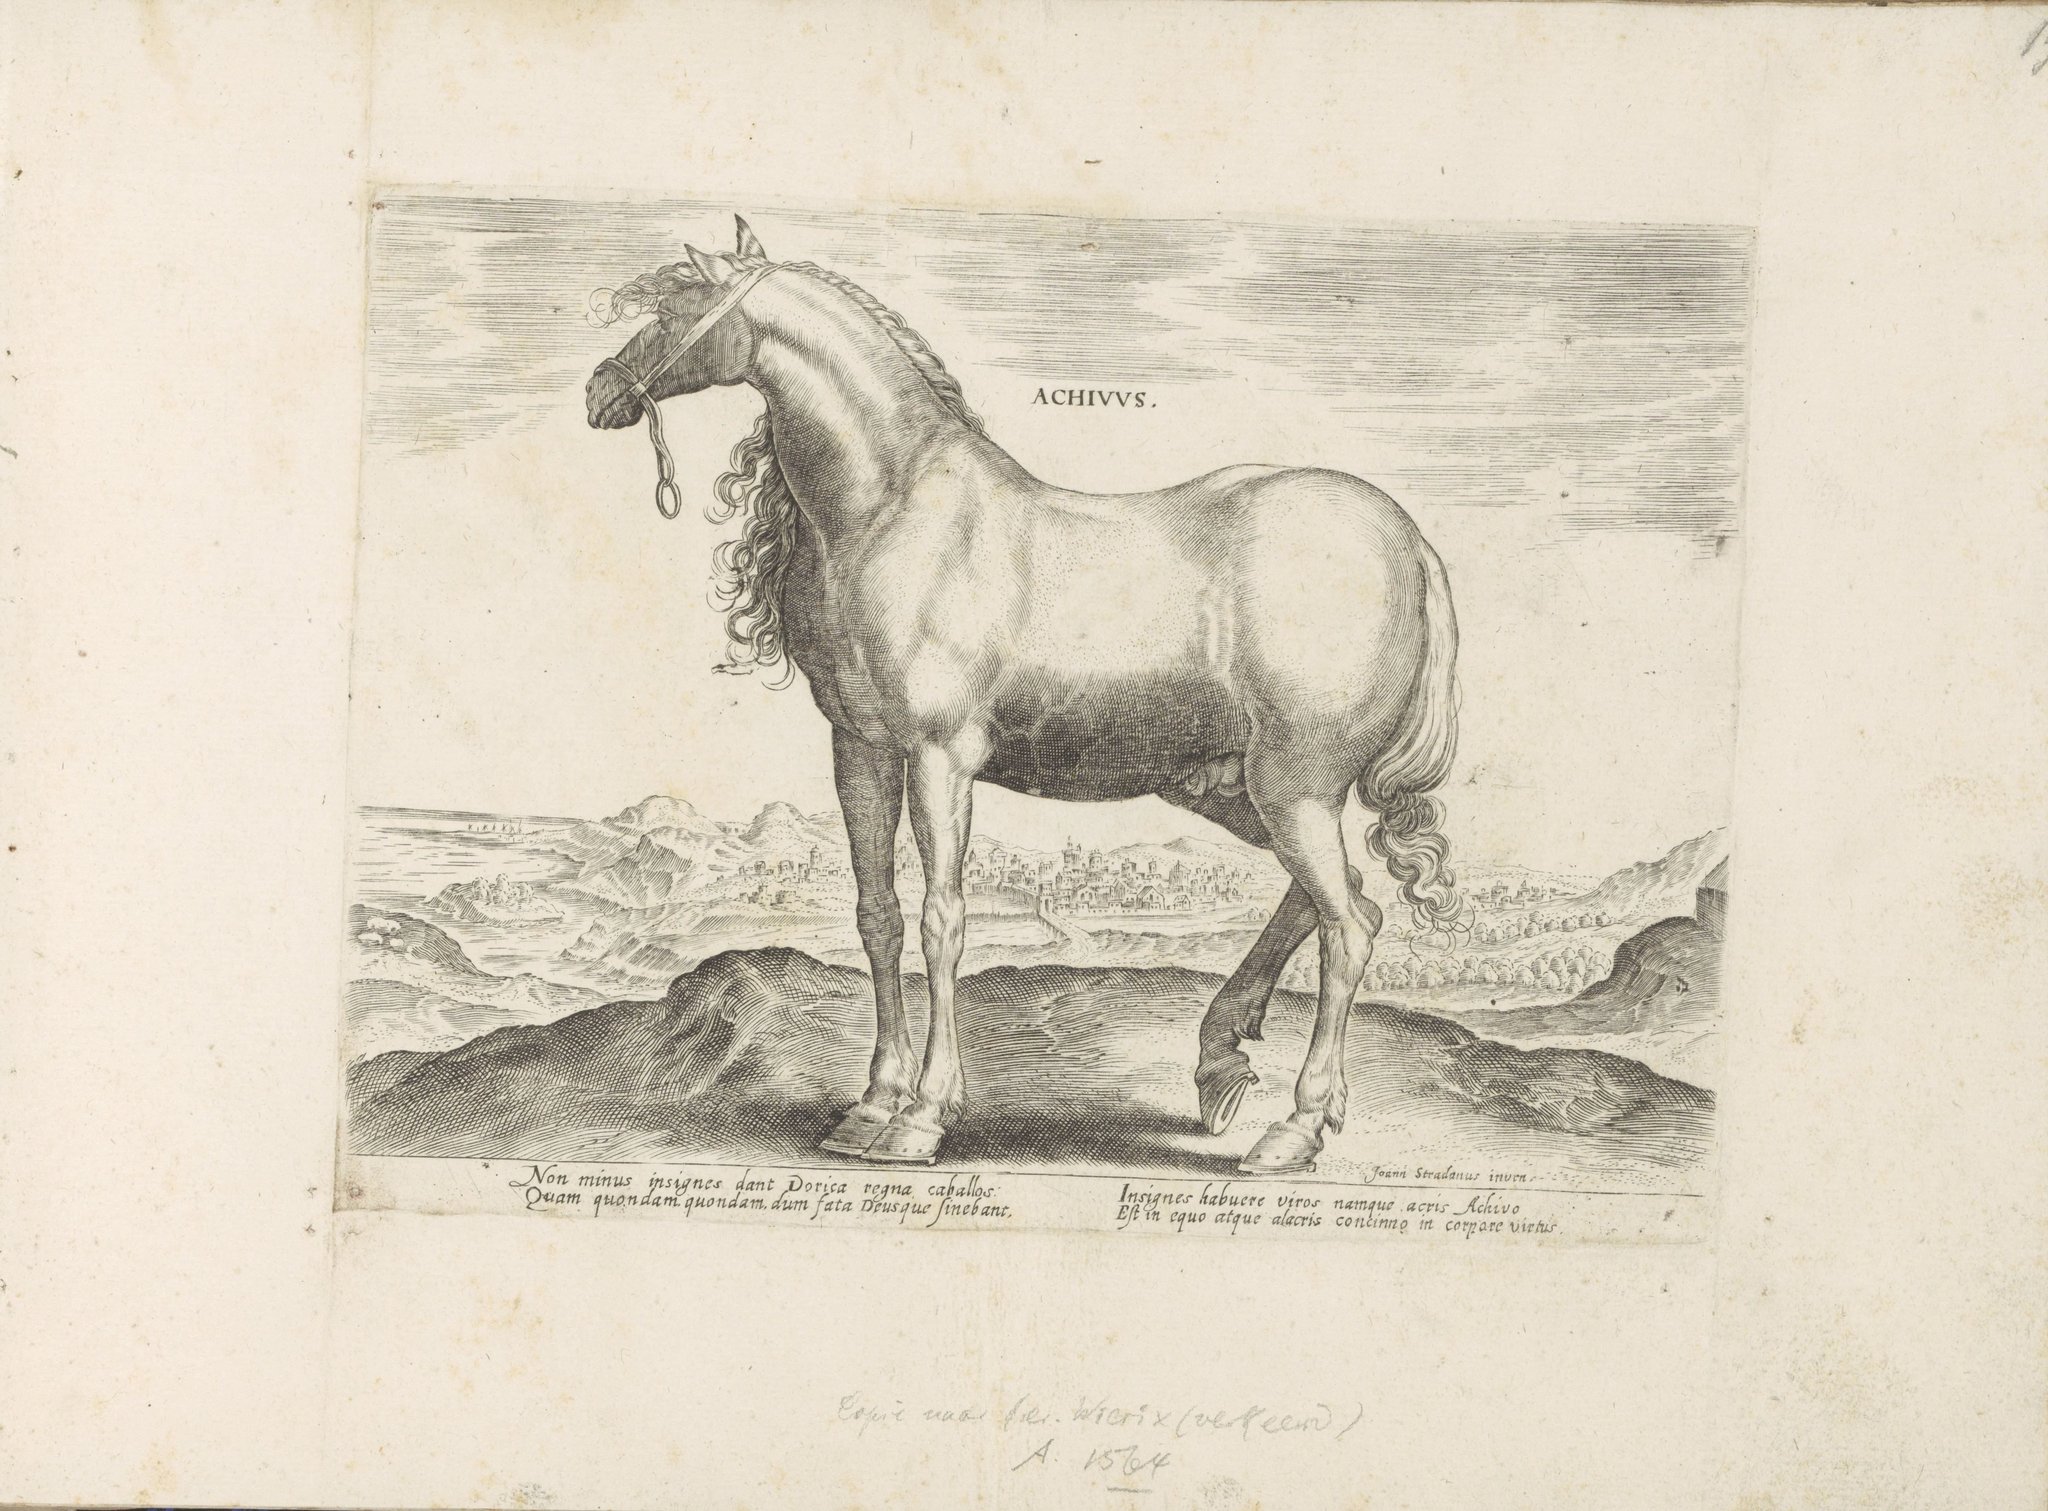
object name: print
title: Achivus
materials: paper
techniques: engraving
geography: venice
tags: don juan van oostenrijk, horses and kindred animals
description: Een Grieks paard in een landschap. Prent maakt deel uit van een album.